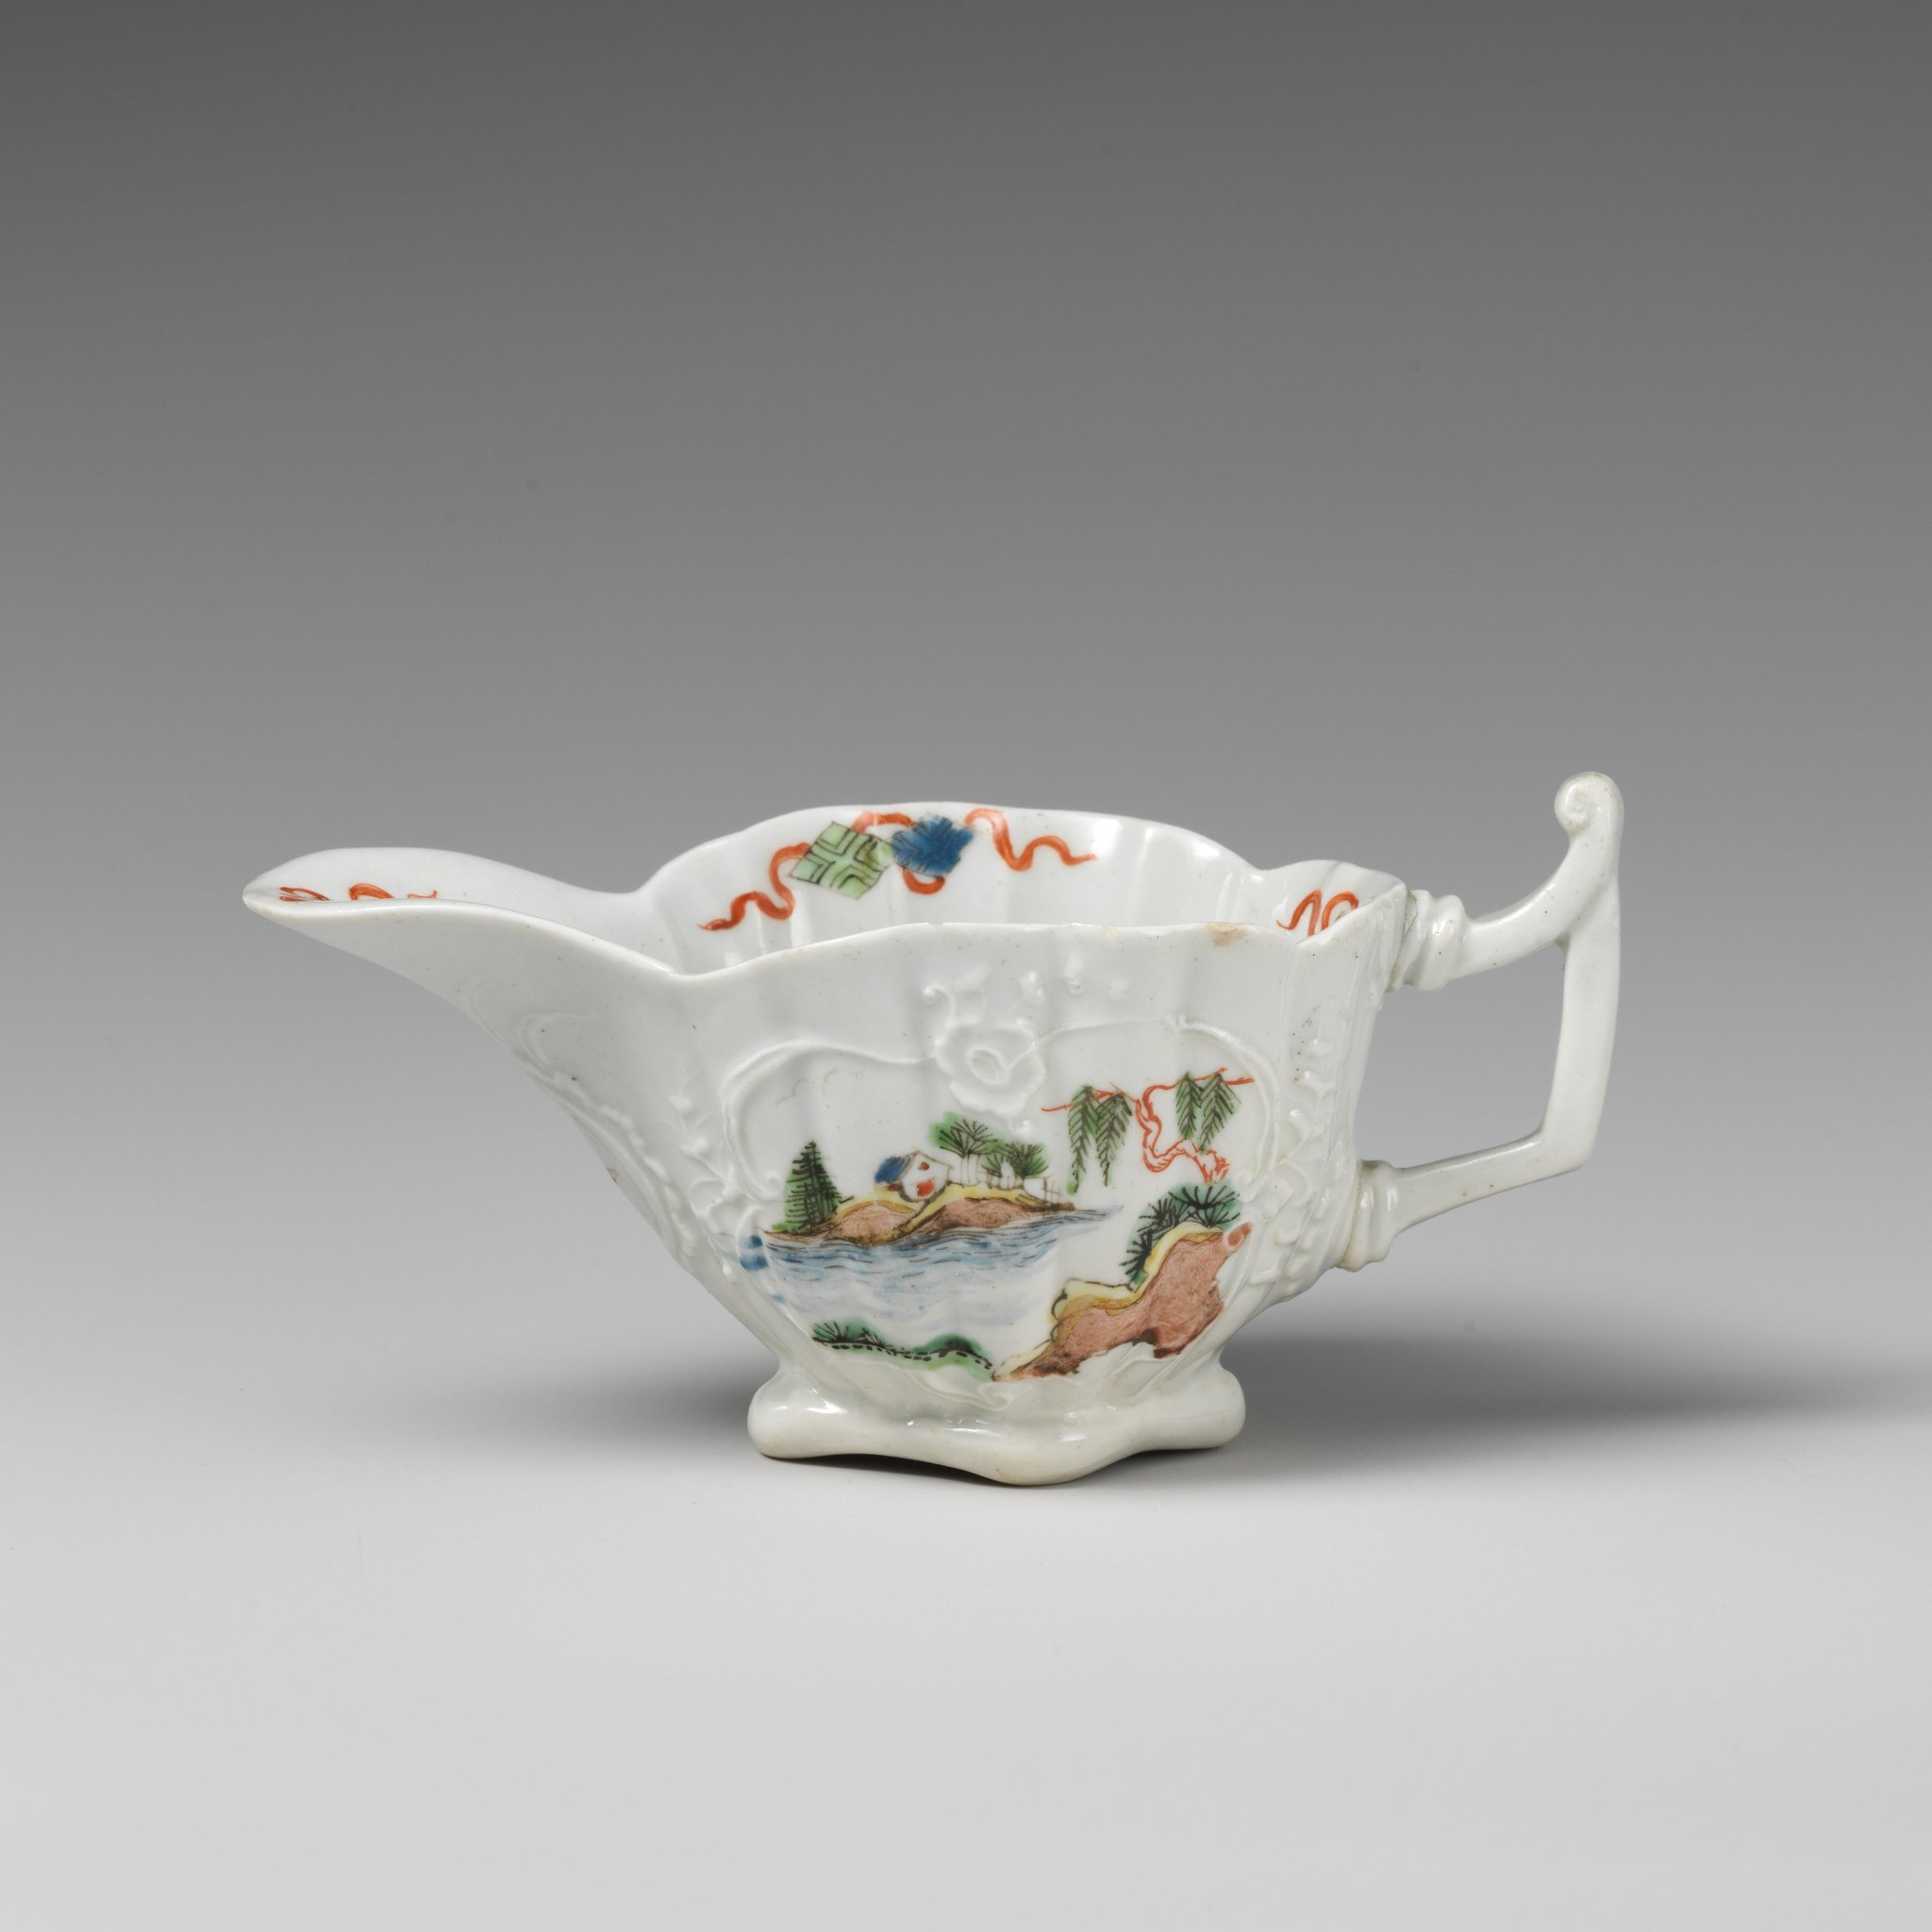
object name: creamboat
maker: worcester factory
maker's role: factory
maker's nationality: british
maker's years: 1751-2008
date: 1753-1755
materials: soft paste porcelain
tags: houses,flowers,landscapes